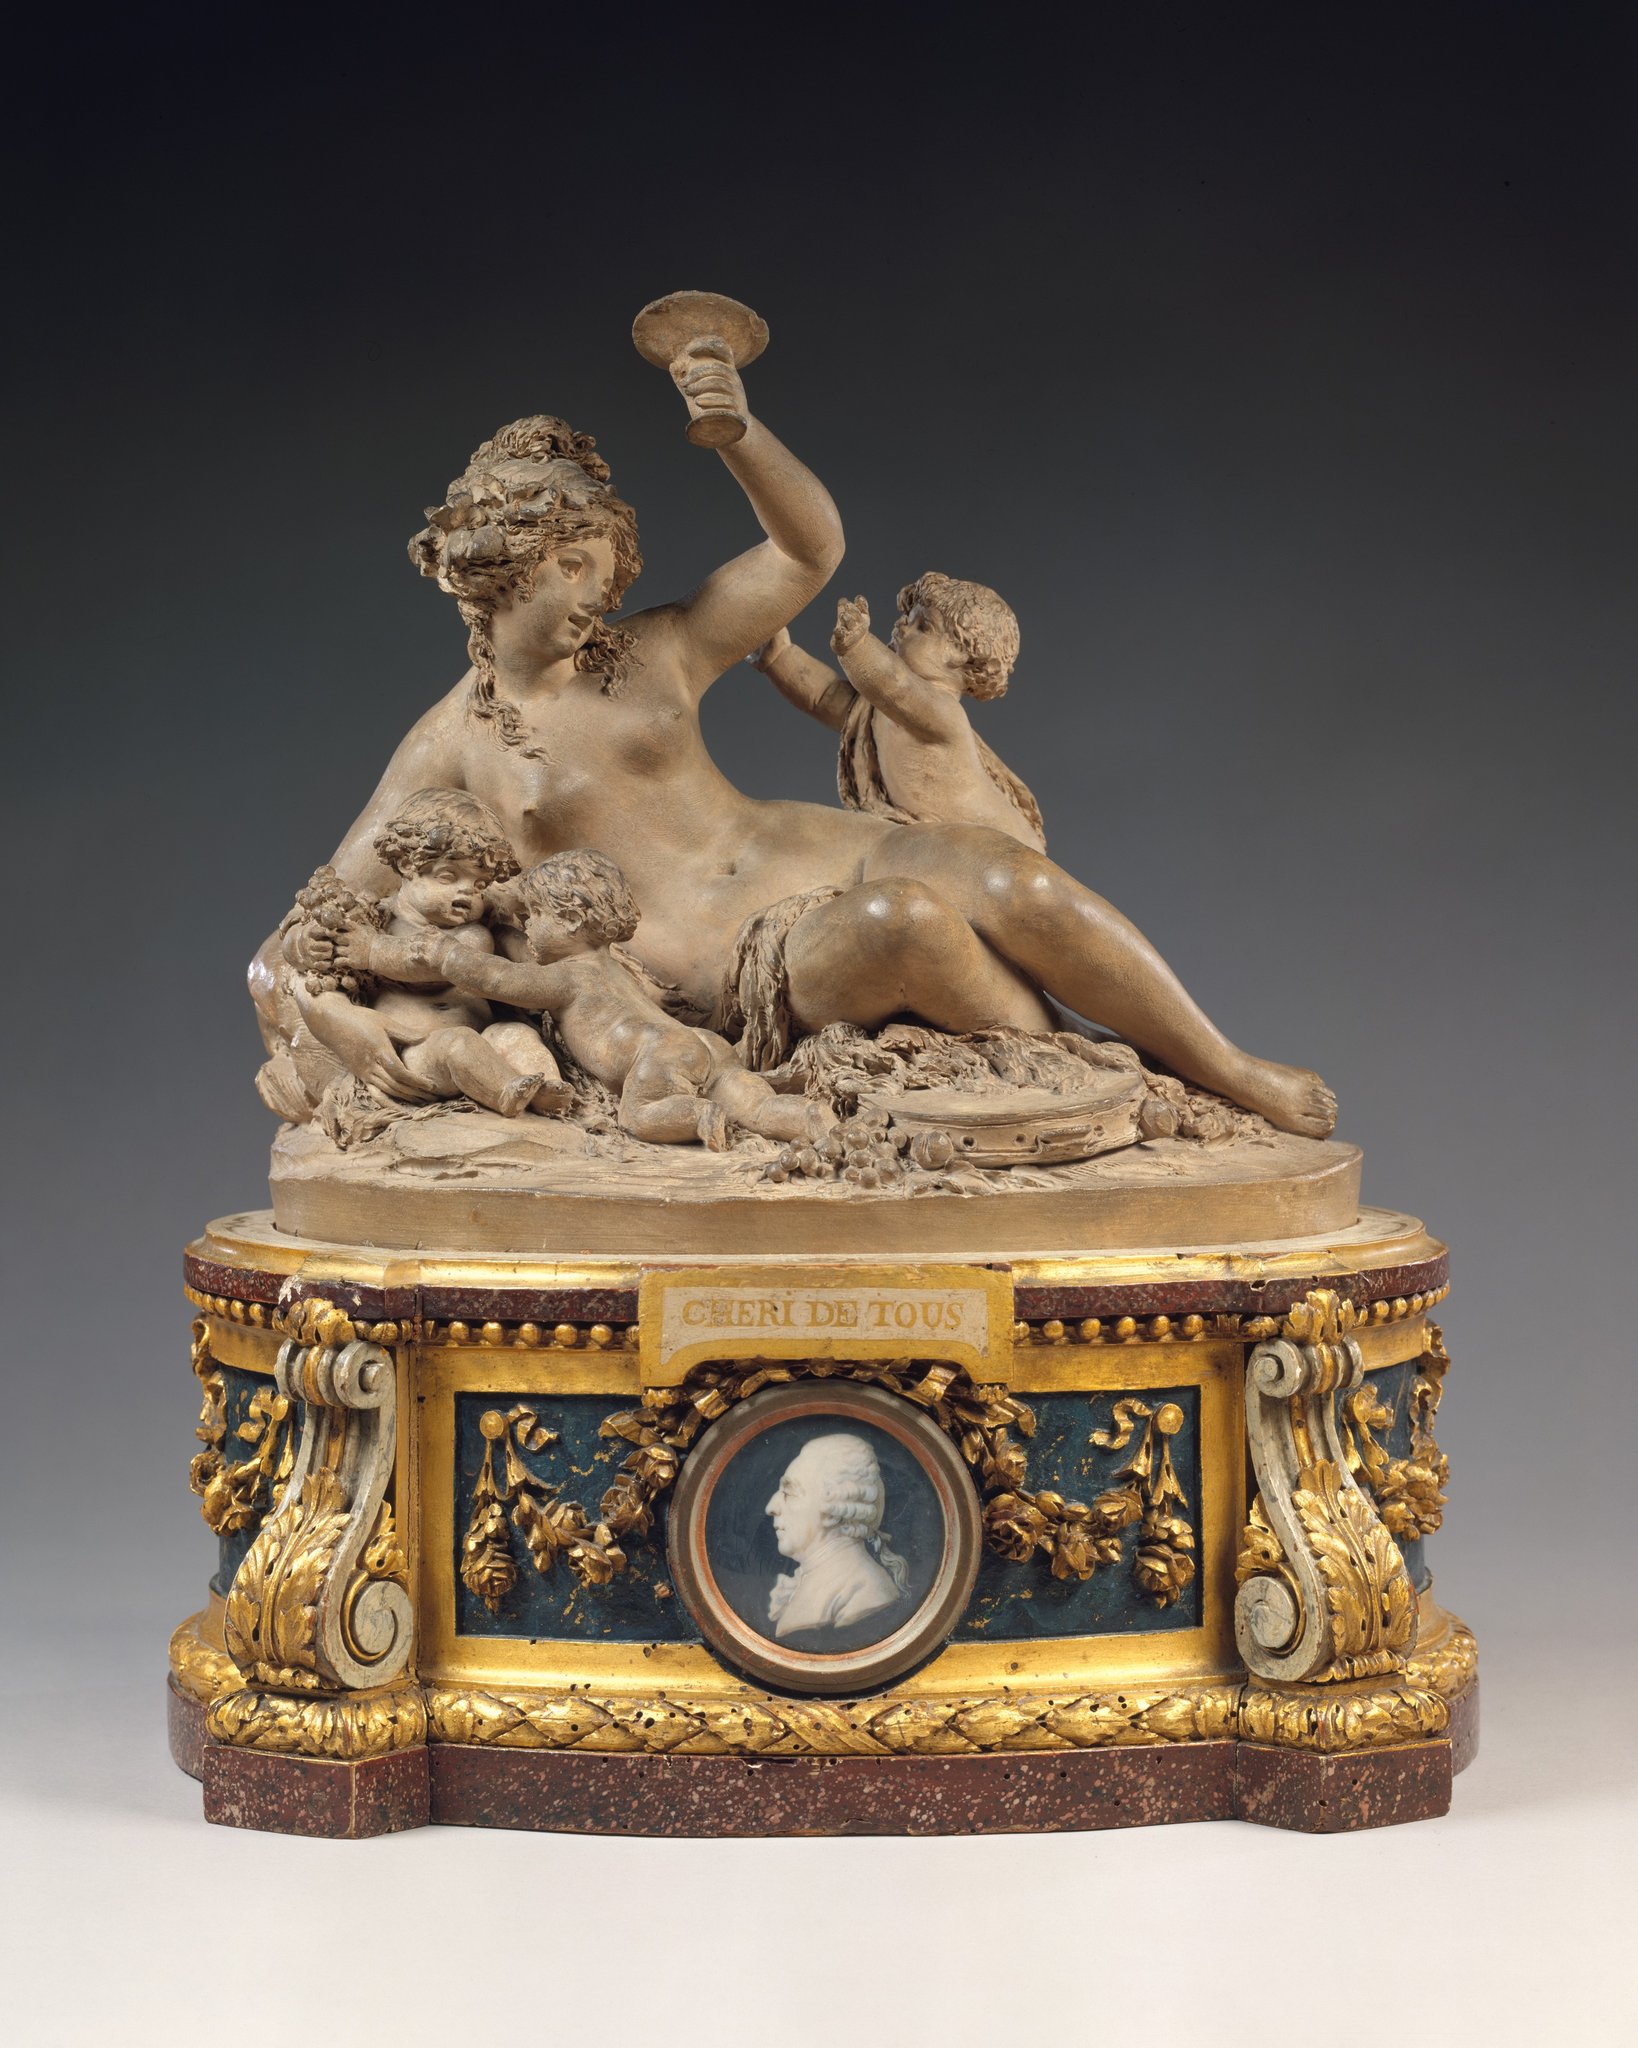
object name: statuette group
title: Bacchante with chalice and three infants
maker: joseph-charles marin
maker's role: artist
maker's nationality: french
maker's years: 1759-1834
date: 1767-1800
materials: gilt, terracotta, wood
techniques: painting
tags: infants,profiles,female nudes,bacchantes,chalices